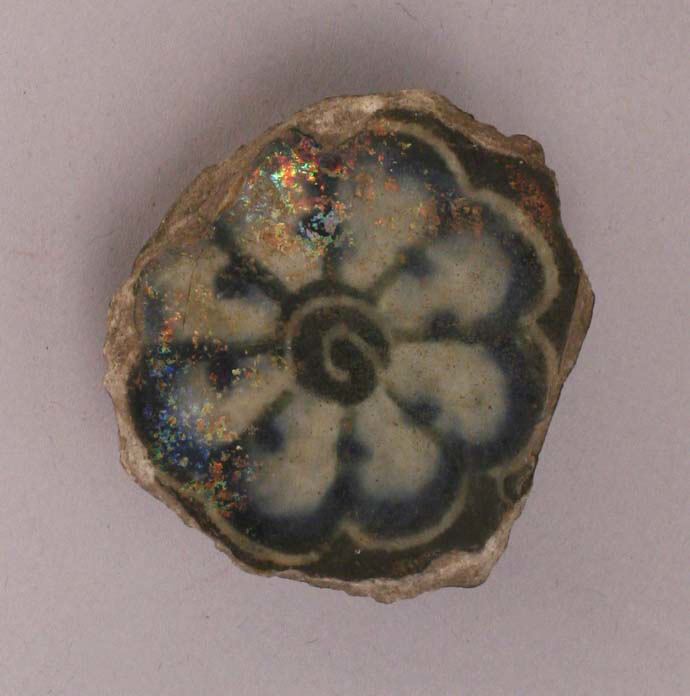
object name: fragment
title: Fragment of a Bowl or Cup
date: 1201-1600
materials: glaze, stonepaste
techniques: painting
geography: egypt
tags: flowers